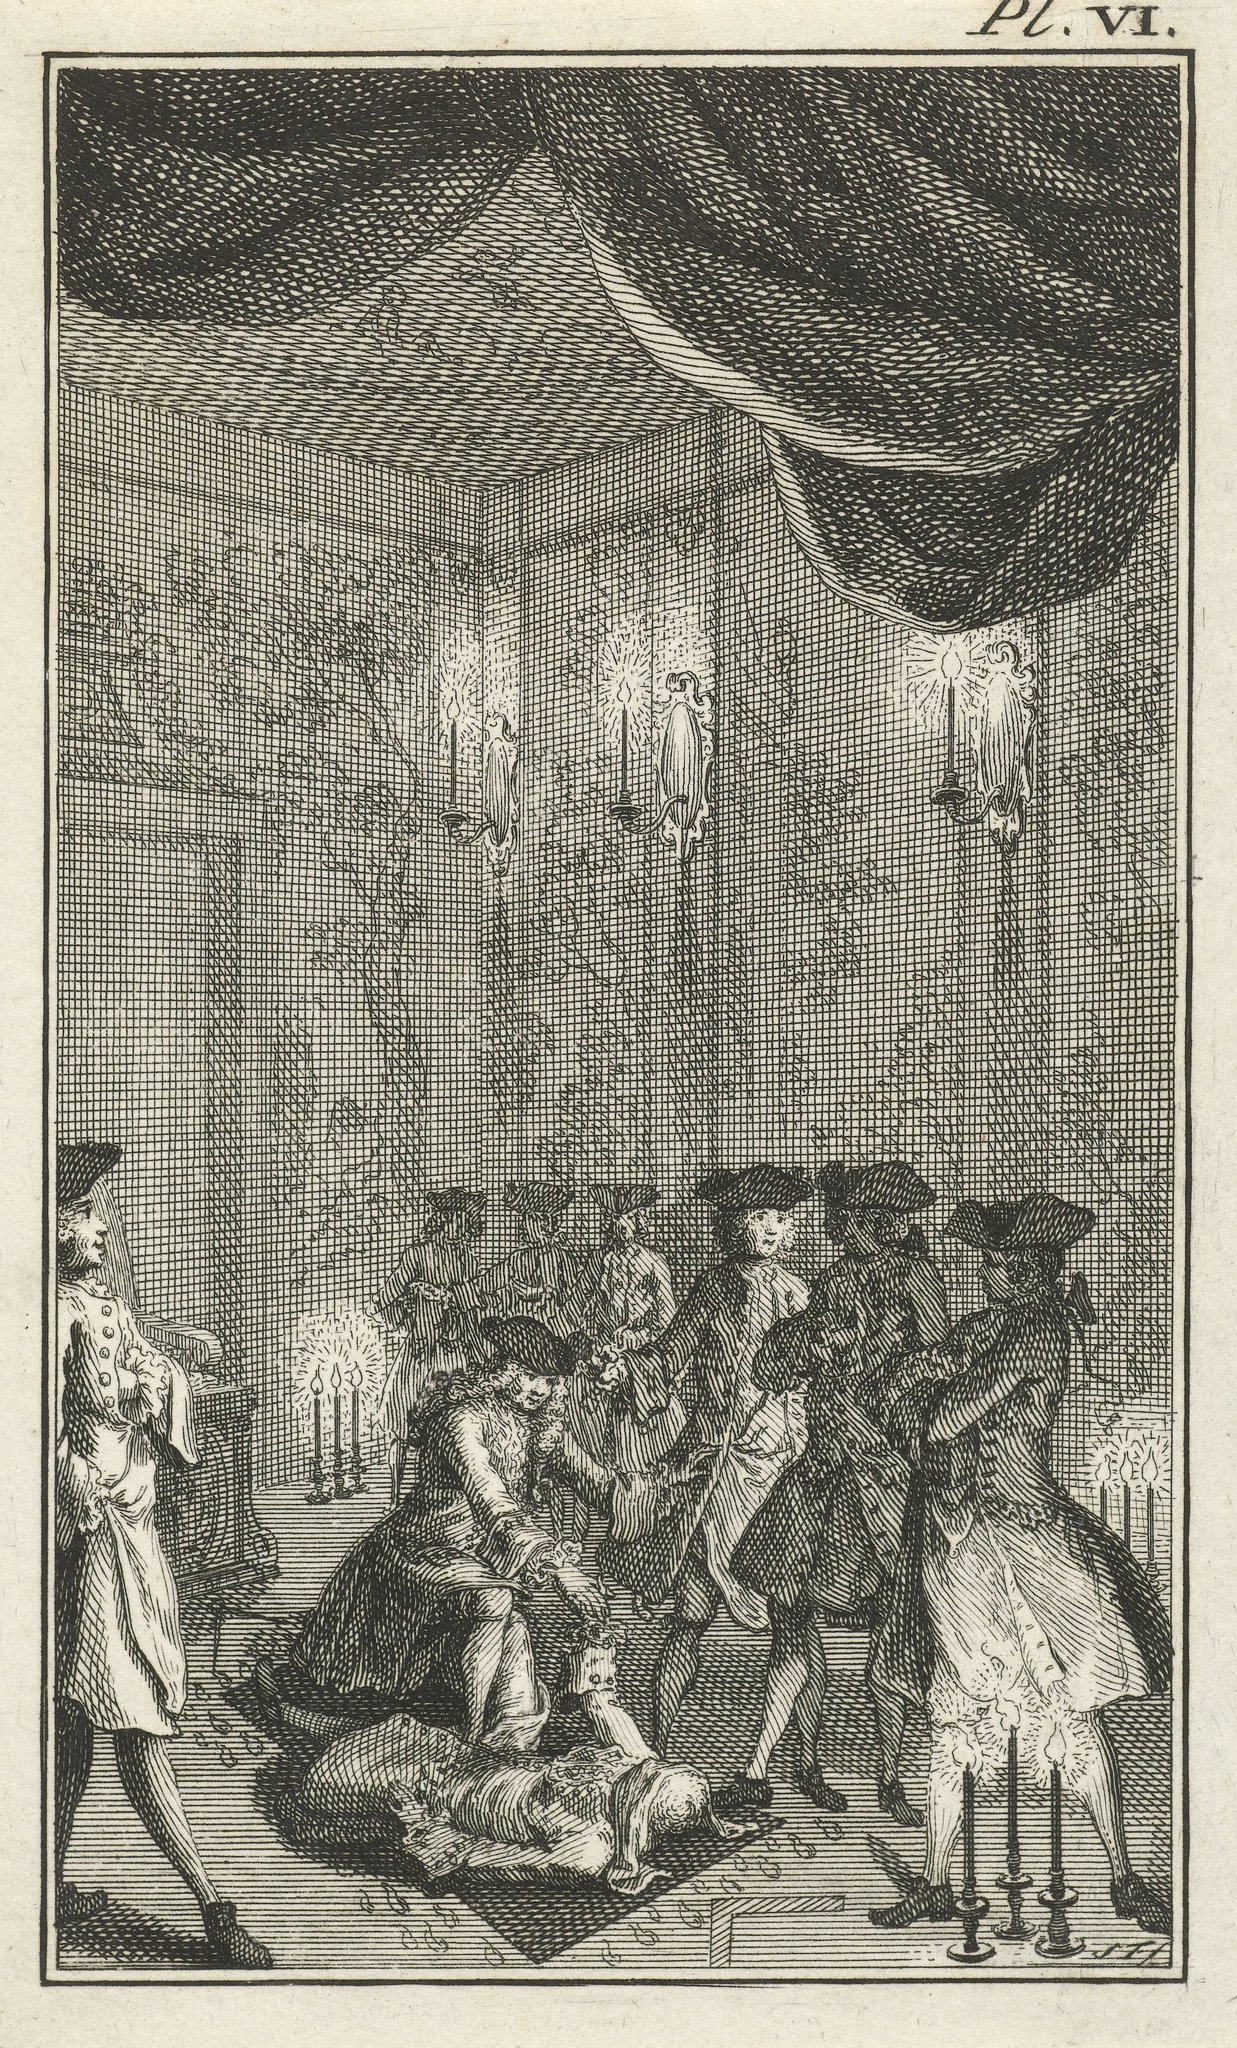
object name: book illustration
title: Liggende man te midden van heren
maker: simon fokke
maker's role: draughtsman, print maker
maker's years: 1712-1784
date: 1722-1784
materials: paper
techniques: engraving, etching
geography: amsterdam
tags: lying figure, violent death by cleaving and striking weapons - ee - death not certain; wounded person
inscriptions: collector's mark: Lugt 240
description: Op de grond in een vertrek ligt een man met een doek over zijn hoofd. Een man knielt bij hem neer terwijl de rest van de groep heren toekijkt. Prent rechtsboven gemerkt: Pl. VI.